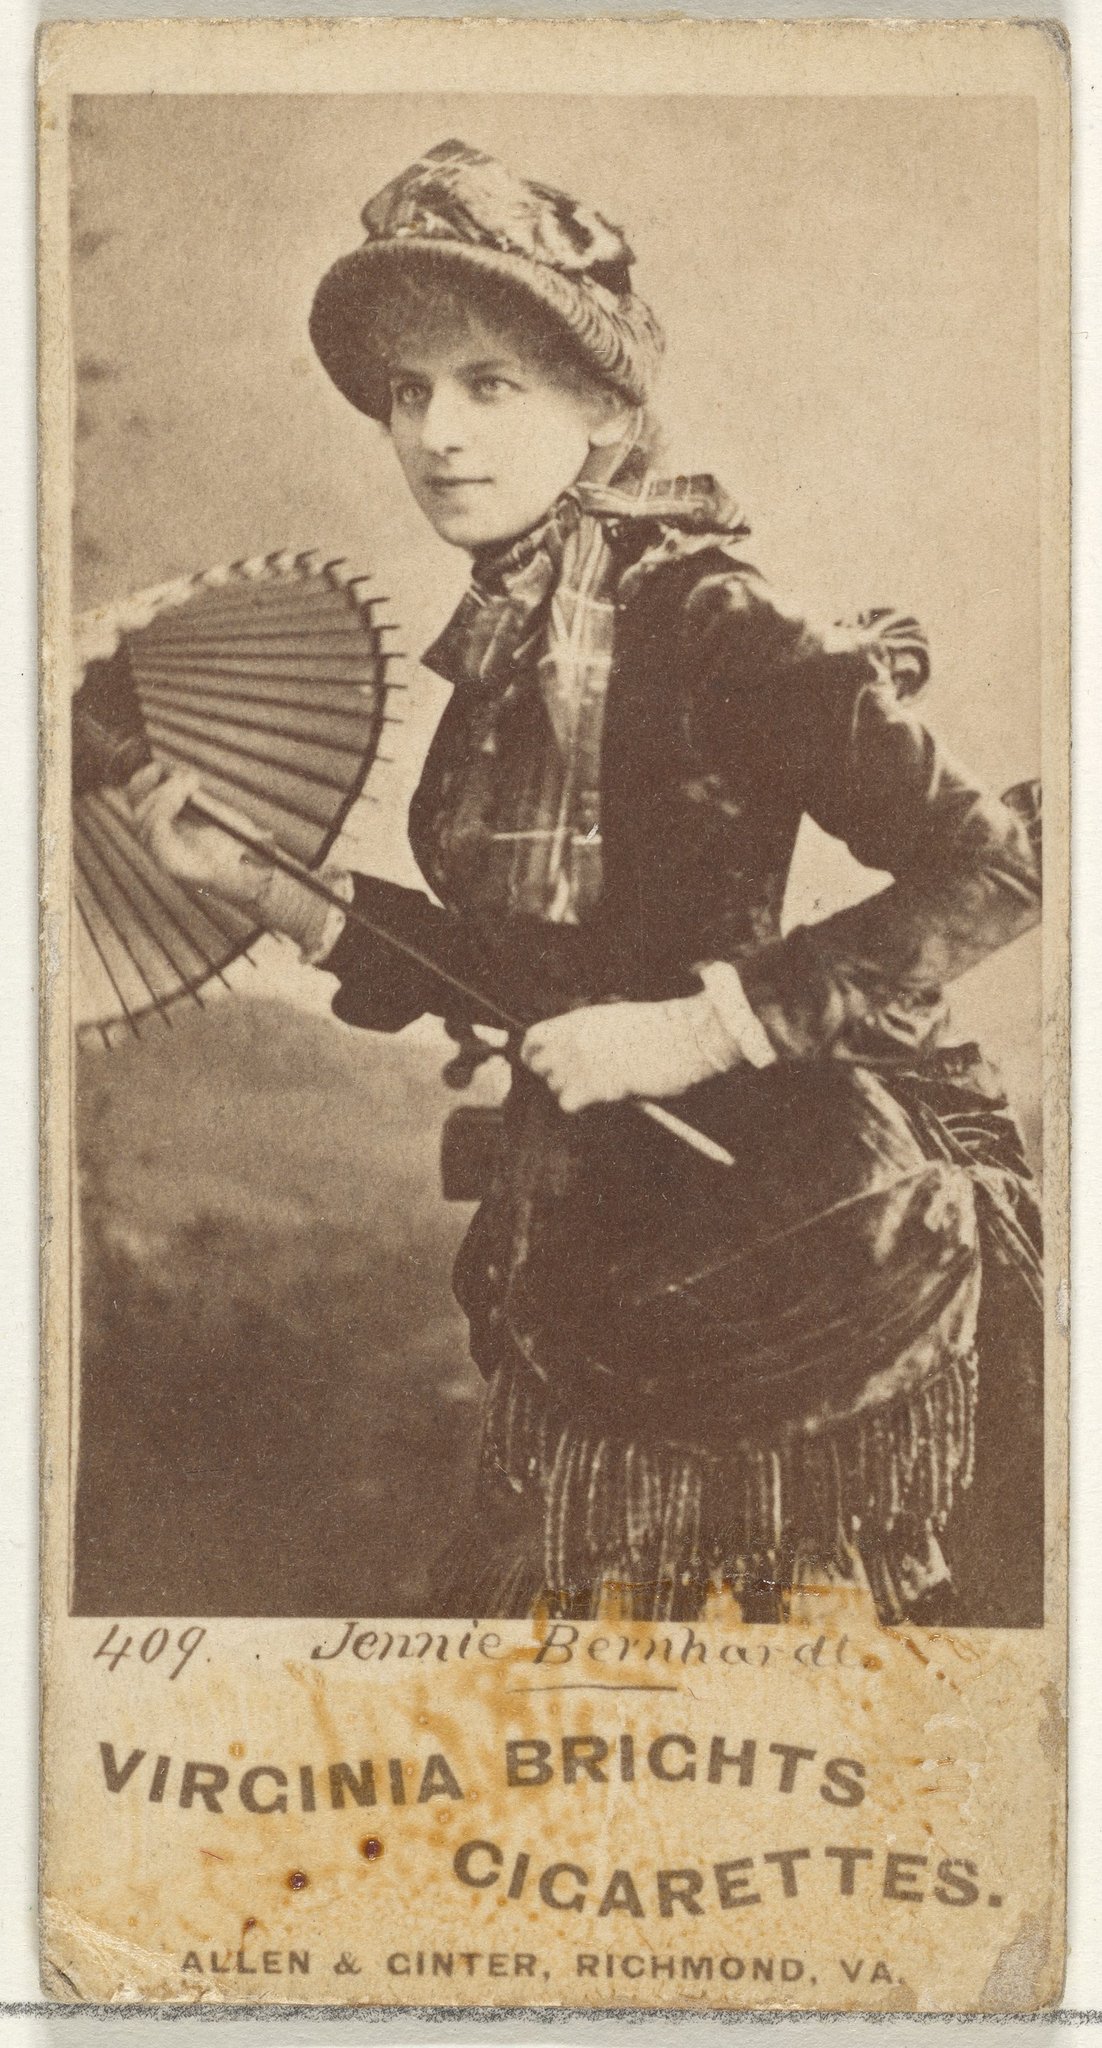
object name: photograph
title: Card 409, Jennie Bernhardt, from the Actors and Actresses series (N45, Type 1) for Virginia Brights Cigarettes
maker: allen & ginter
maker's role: publisher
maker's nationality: american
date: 1888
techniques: albumen silver print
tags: portraits,women,actresses,parasols